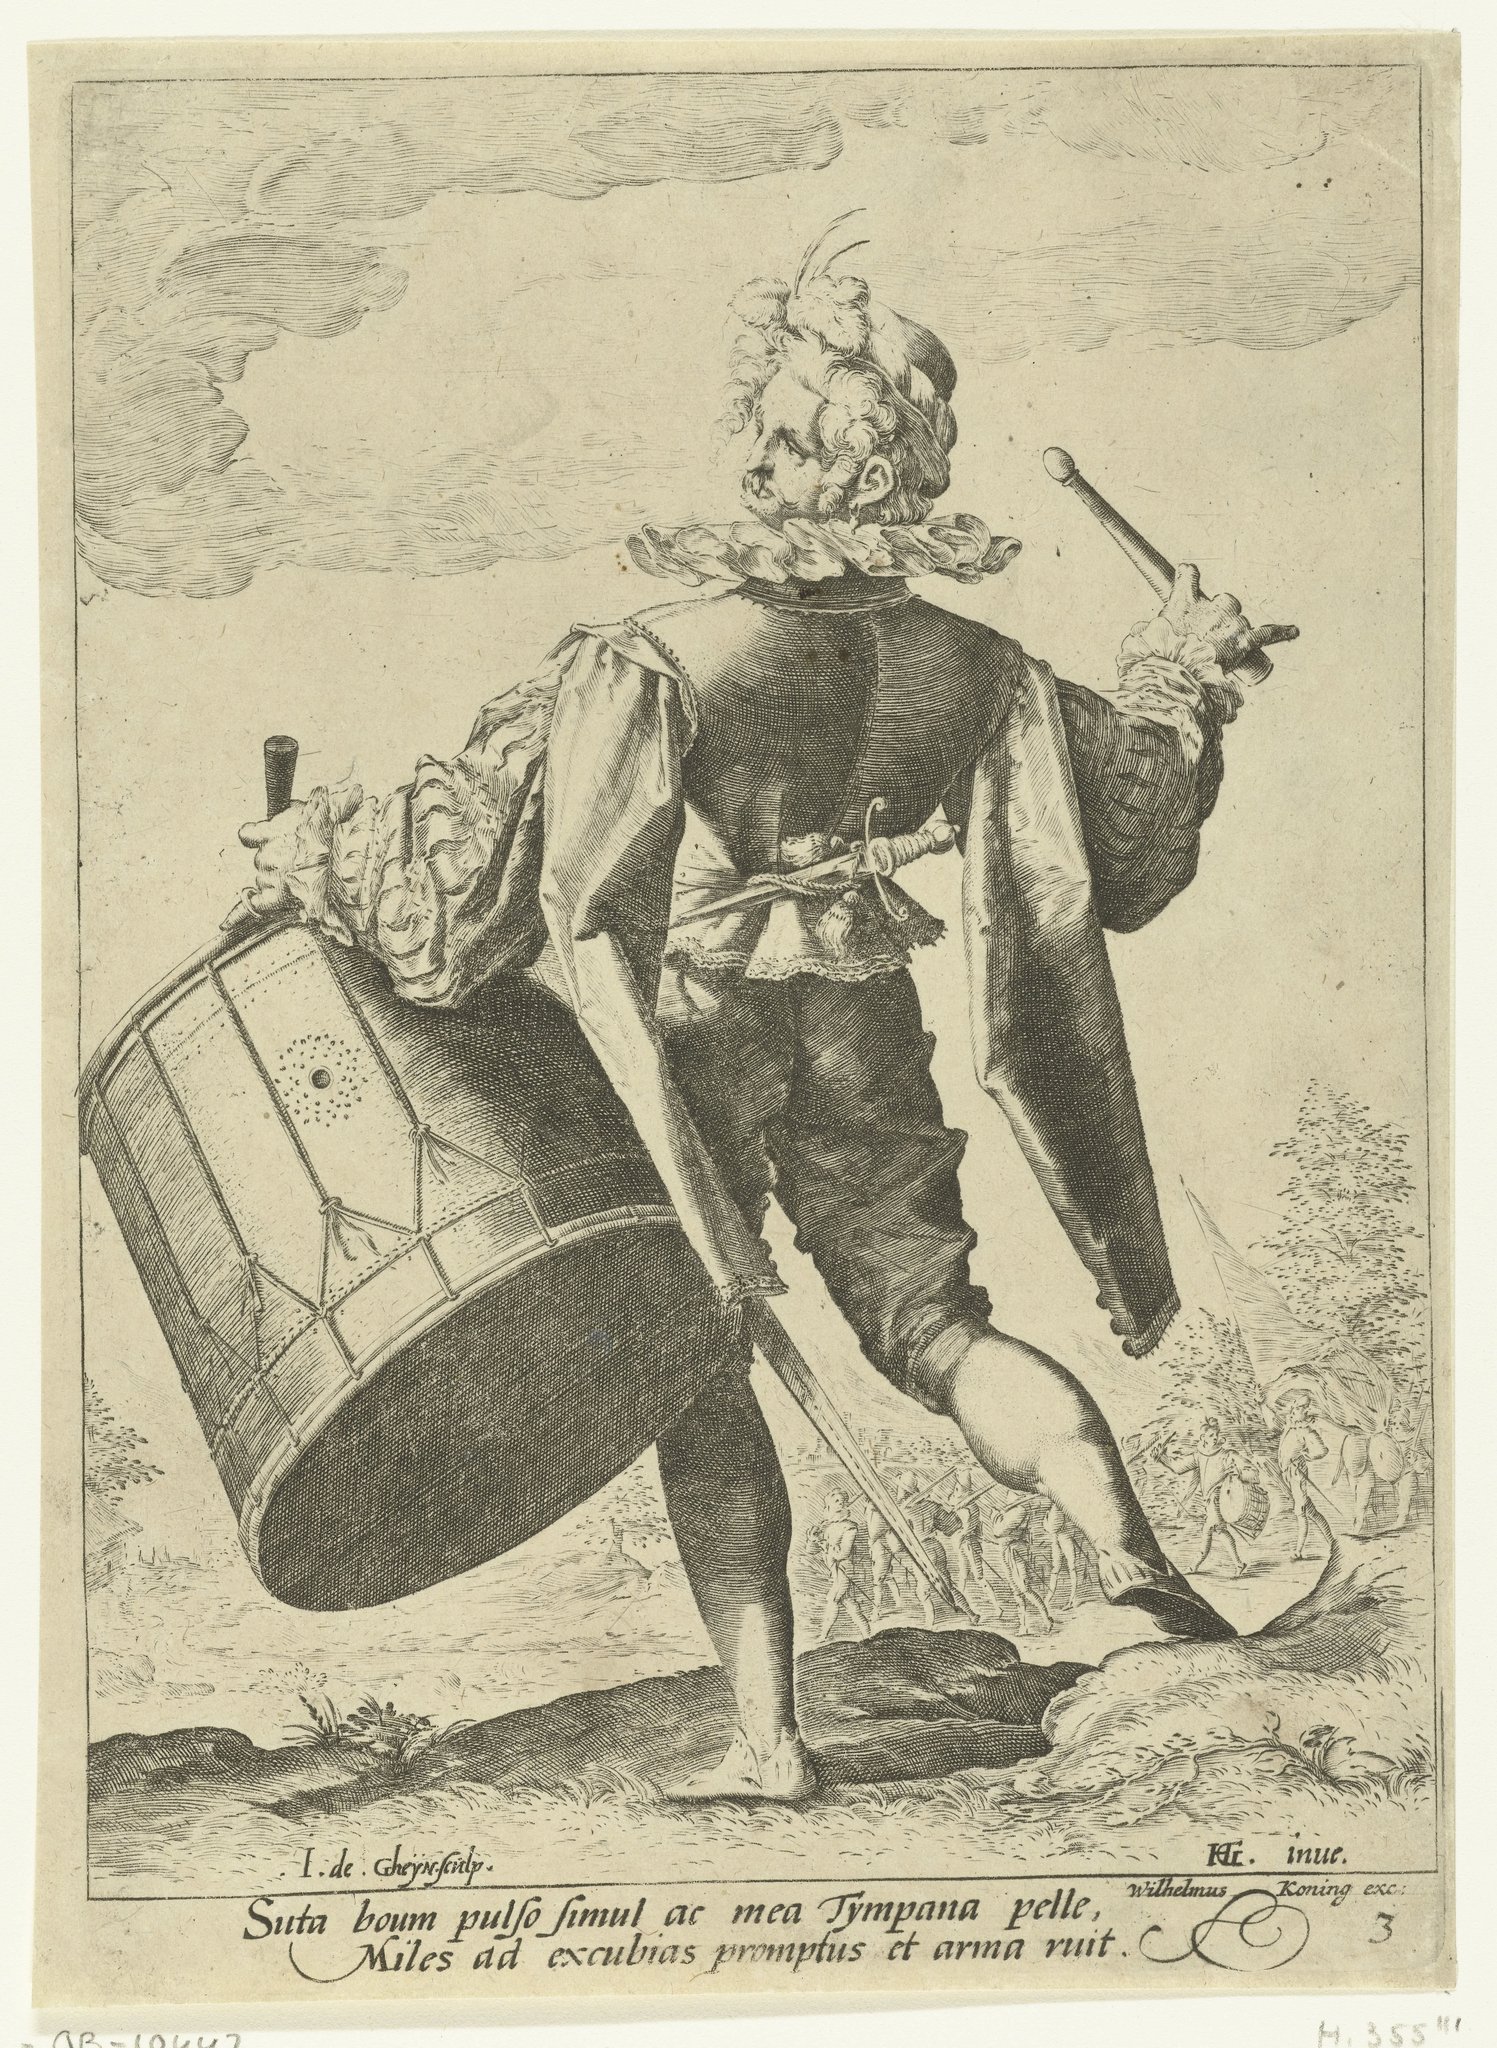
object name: print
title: Tamboer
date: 1587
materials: paper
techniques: engraving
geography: amsterdam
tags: troop movements, transportation, ranks in the army, one person playing percussion instrument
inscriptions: collector's mark: Lugt 2228a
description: Een man met een grote trom aan zijn linkerzijde en een stok in zijn geheven rechterhand (een tamboer), ten voeten uit, op de rug gezien. Op de achtergrond een heuvelachtig landschap waarin een troep soldaten marcheert. Onder de voorstelling twee regels tekst in Latijn. Deze prent is onderdeel van een serie van 12 genummerde prenten van militairen, ten voeten uit weergegeven tegen een landschappelijke achtergrond waarin krijgshandelingen verricht worden, en met een tweeregelig Latijns onderschrift.